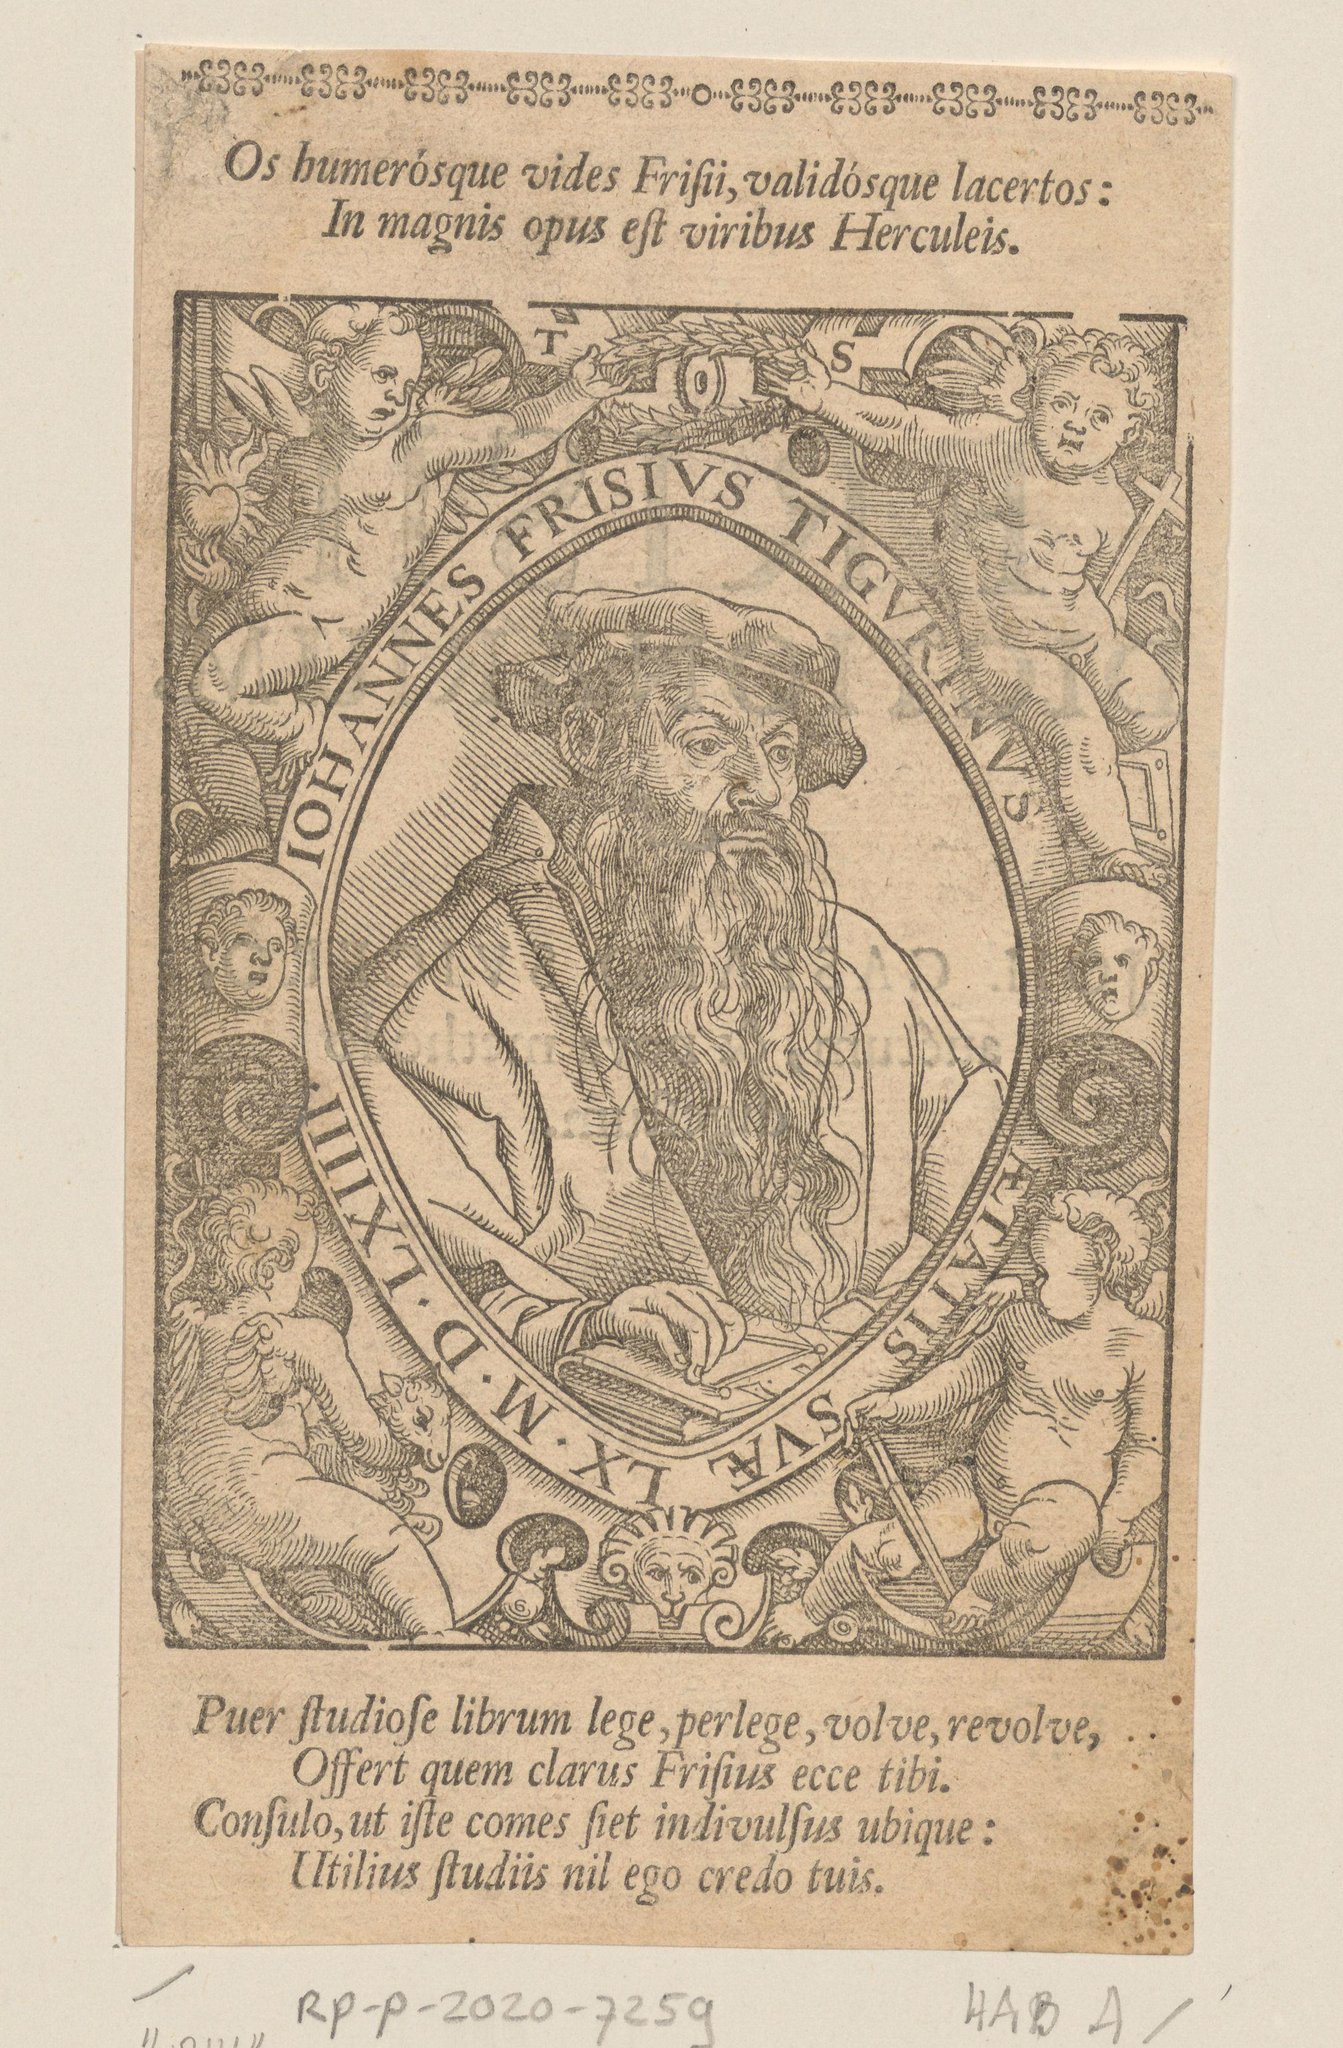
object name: book illustration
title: Portret van Johannes Frisius op 60-jarige leeftijd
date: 1564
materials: paper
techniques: letterpress printing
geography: zurich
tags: theologian, the three theological virtues, historical persons, crowning with laurel, cupids: 'amores', 'amoretti', 'putti'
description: De prent werd voor het eerst uitgegeven in 1564. Prent uit: Frisius, Johannes. Dictionarium latino-germanicum (...). Zürich: Heinrich Bodmer (II), 1712.